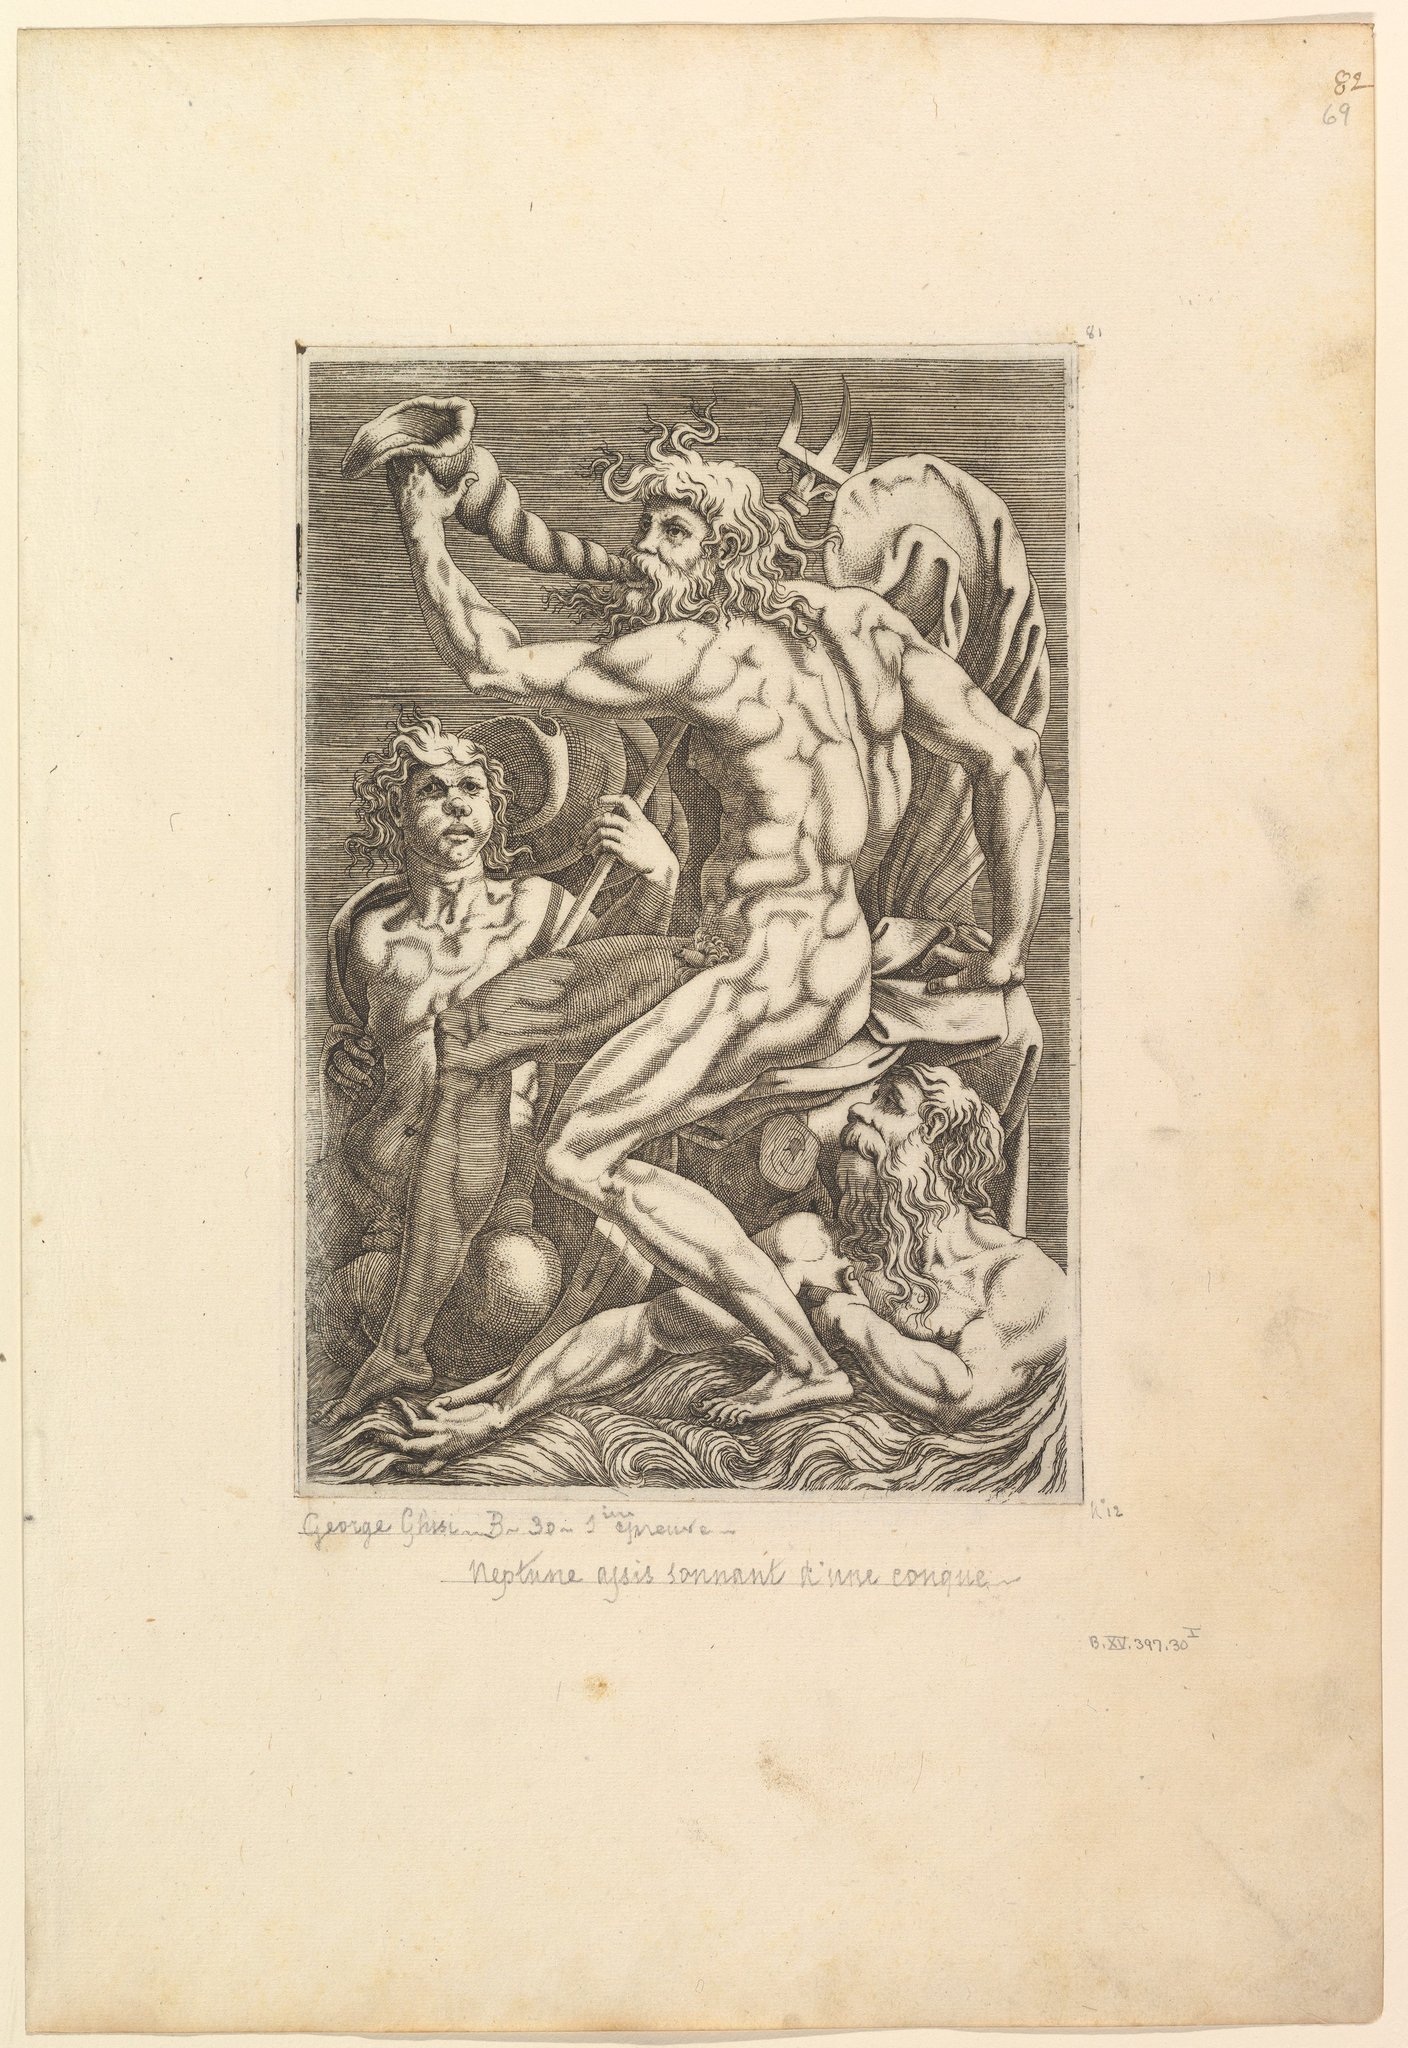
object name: print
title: Neptune Seated Blowing a Conch Shell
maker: anonymous, 16th century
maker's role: artist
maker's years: 1500-1600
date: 1501-1600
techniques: engraving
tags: men,neptune,shells